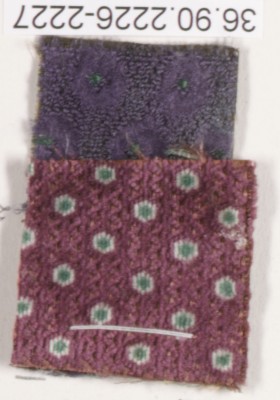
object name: piece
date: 1801-1900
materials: silk